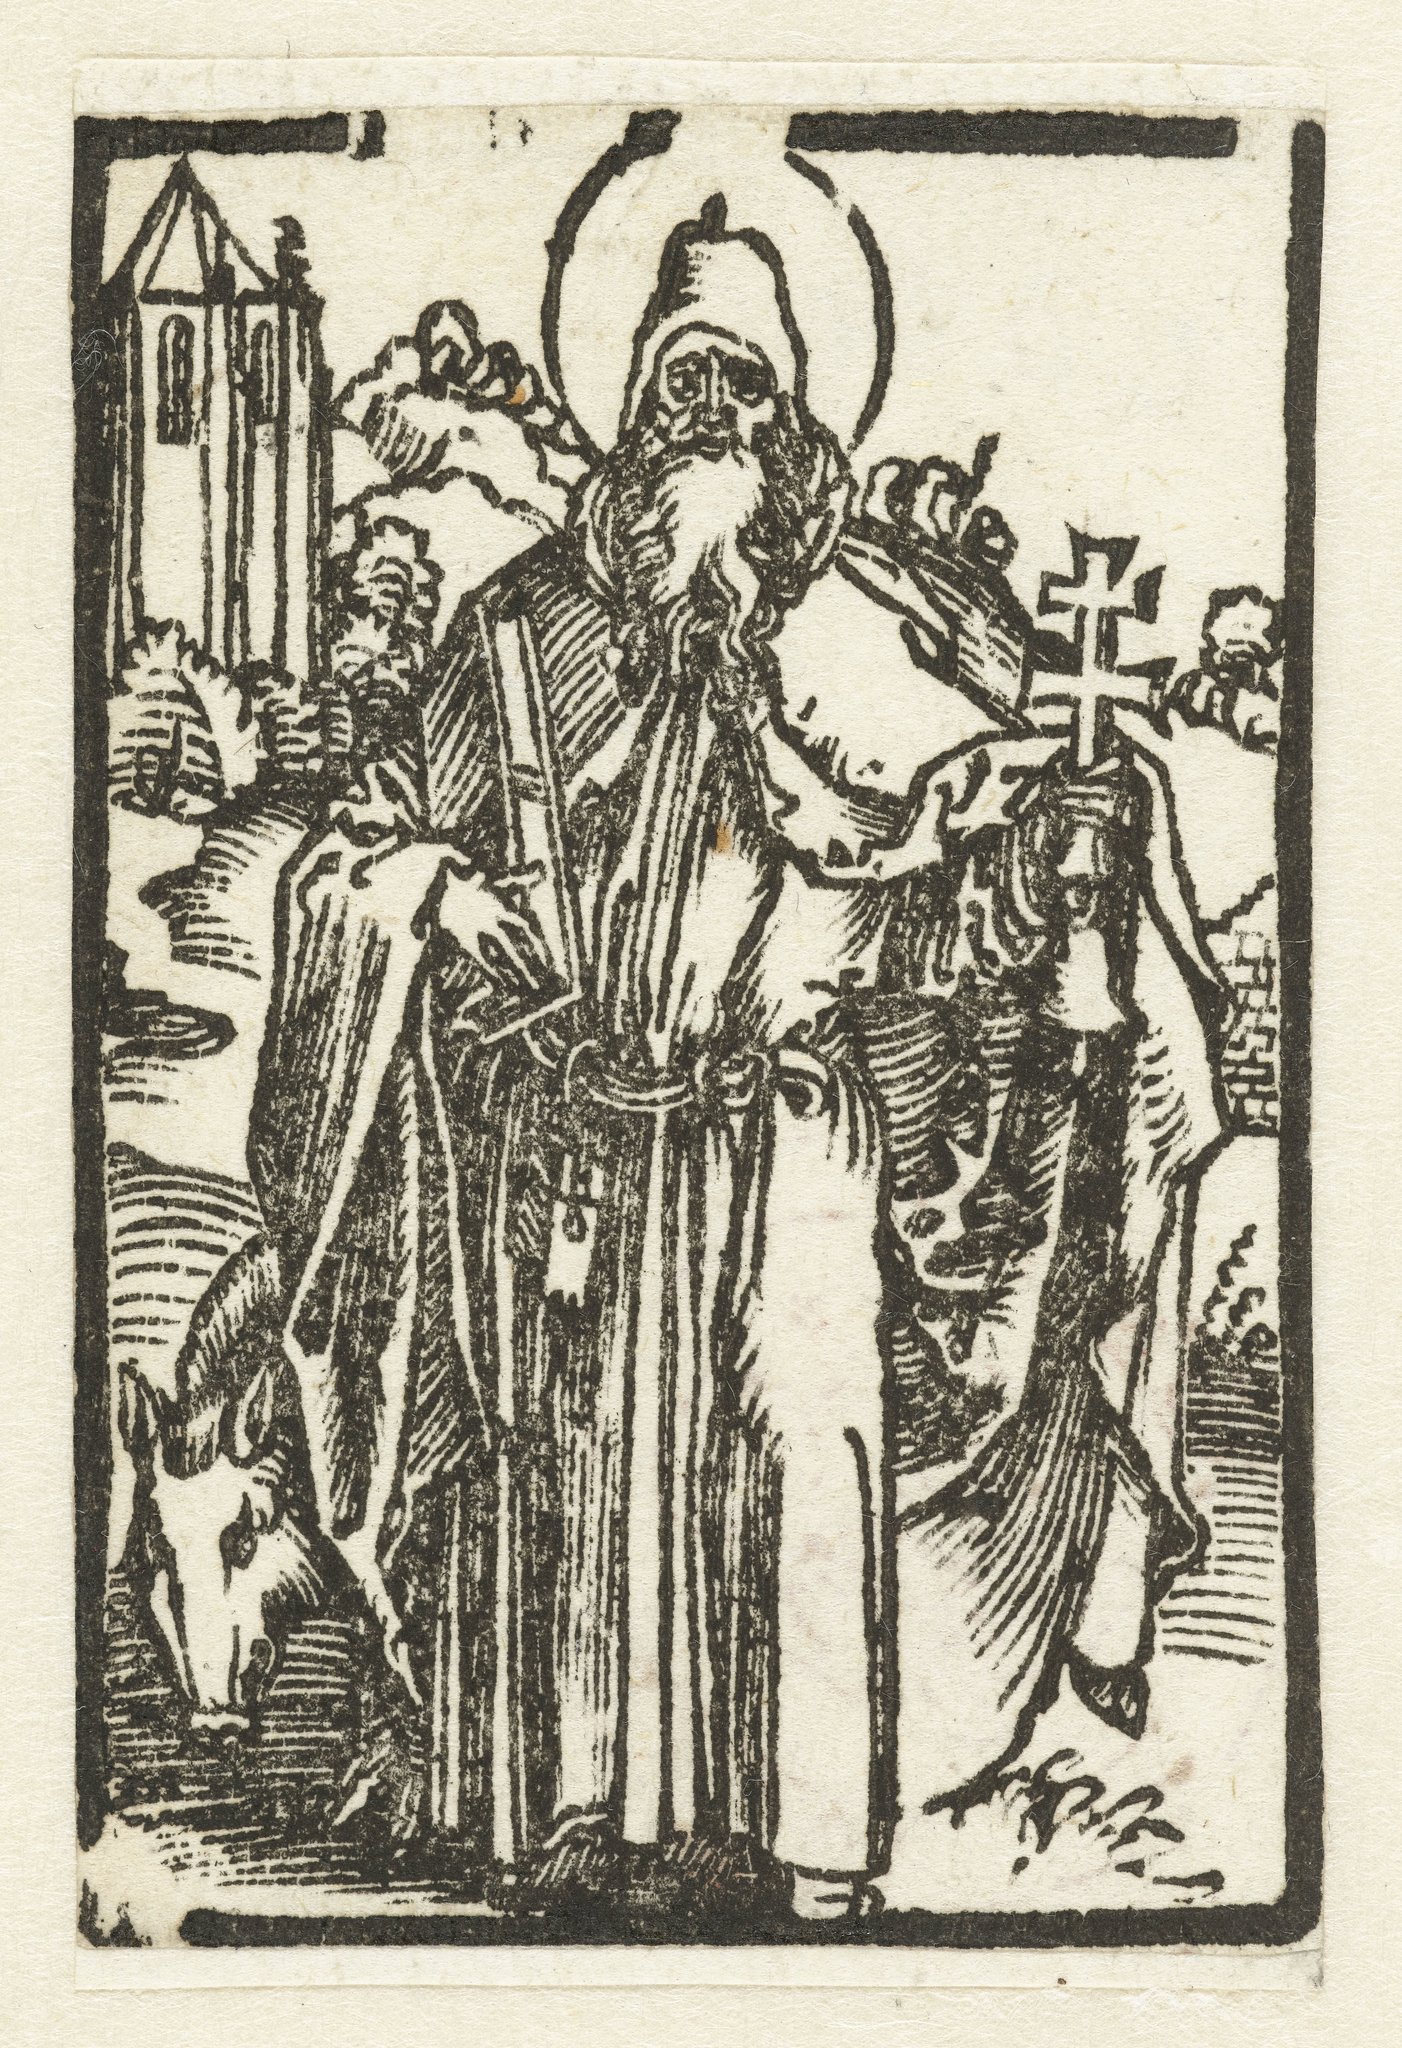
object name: book illustration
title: Heilige Antonius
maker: albrecht dürer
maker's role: draughtsman, painter, print maker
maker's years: 1471-1528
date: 1503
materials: paper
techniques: woodcut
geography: nuremberg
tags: the hermit antony abbot (antonius abbas) of egypt, also called the great; possible attributes: bell, book, t-shaped staff, flames, pig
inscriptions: collector's mark: Lugt 240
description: Illustratie voor: Salus anim[a]e, Neurenberg: Hieronymus Höltzel, 1503. Klinkert, C.